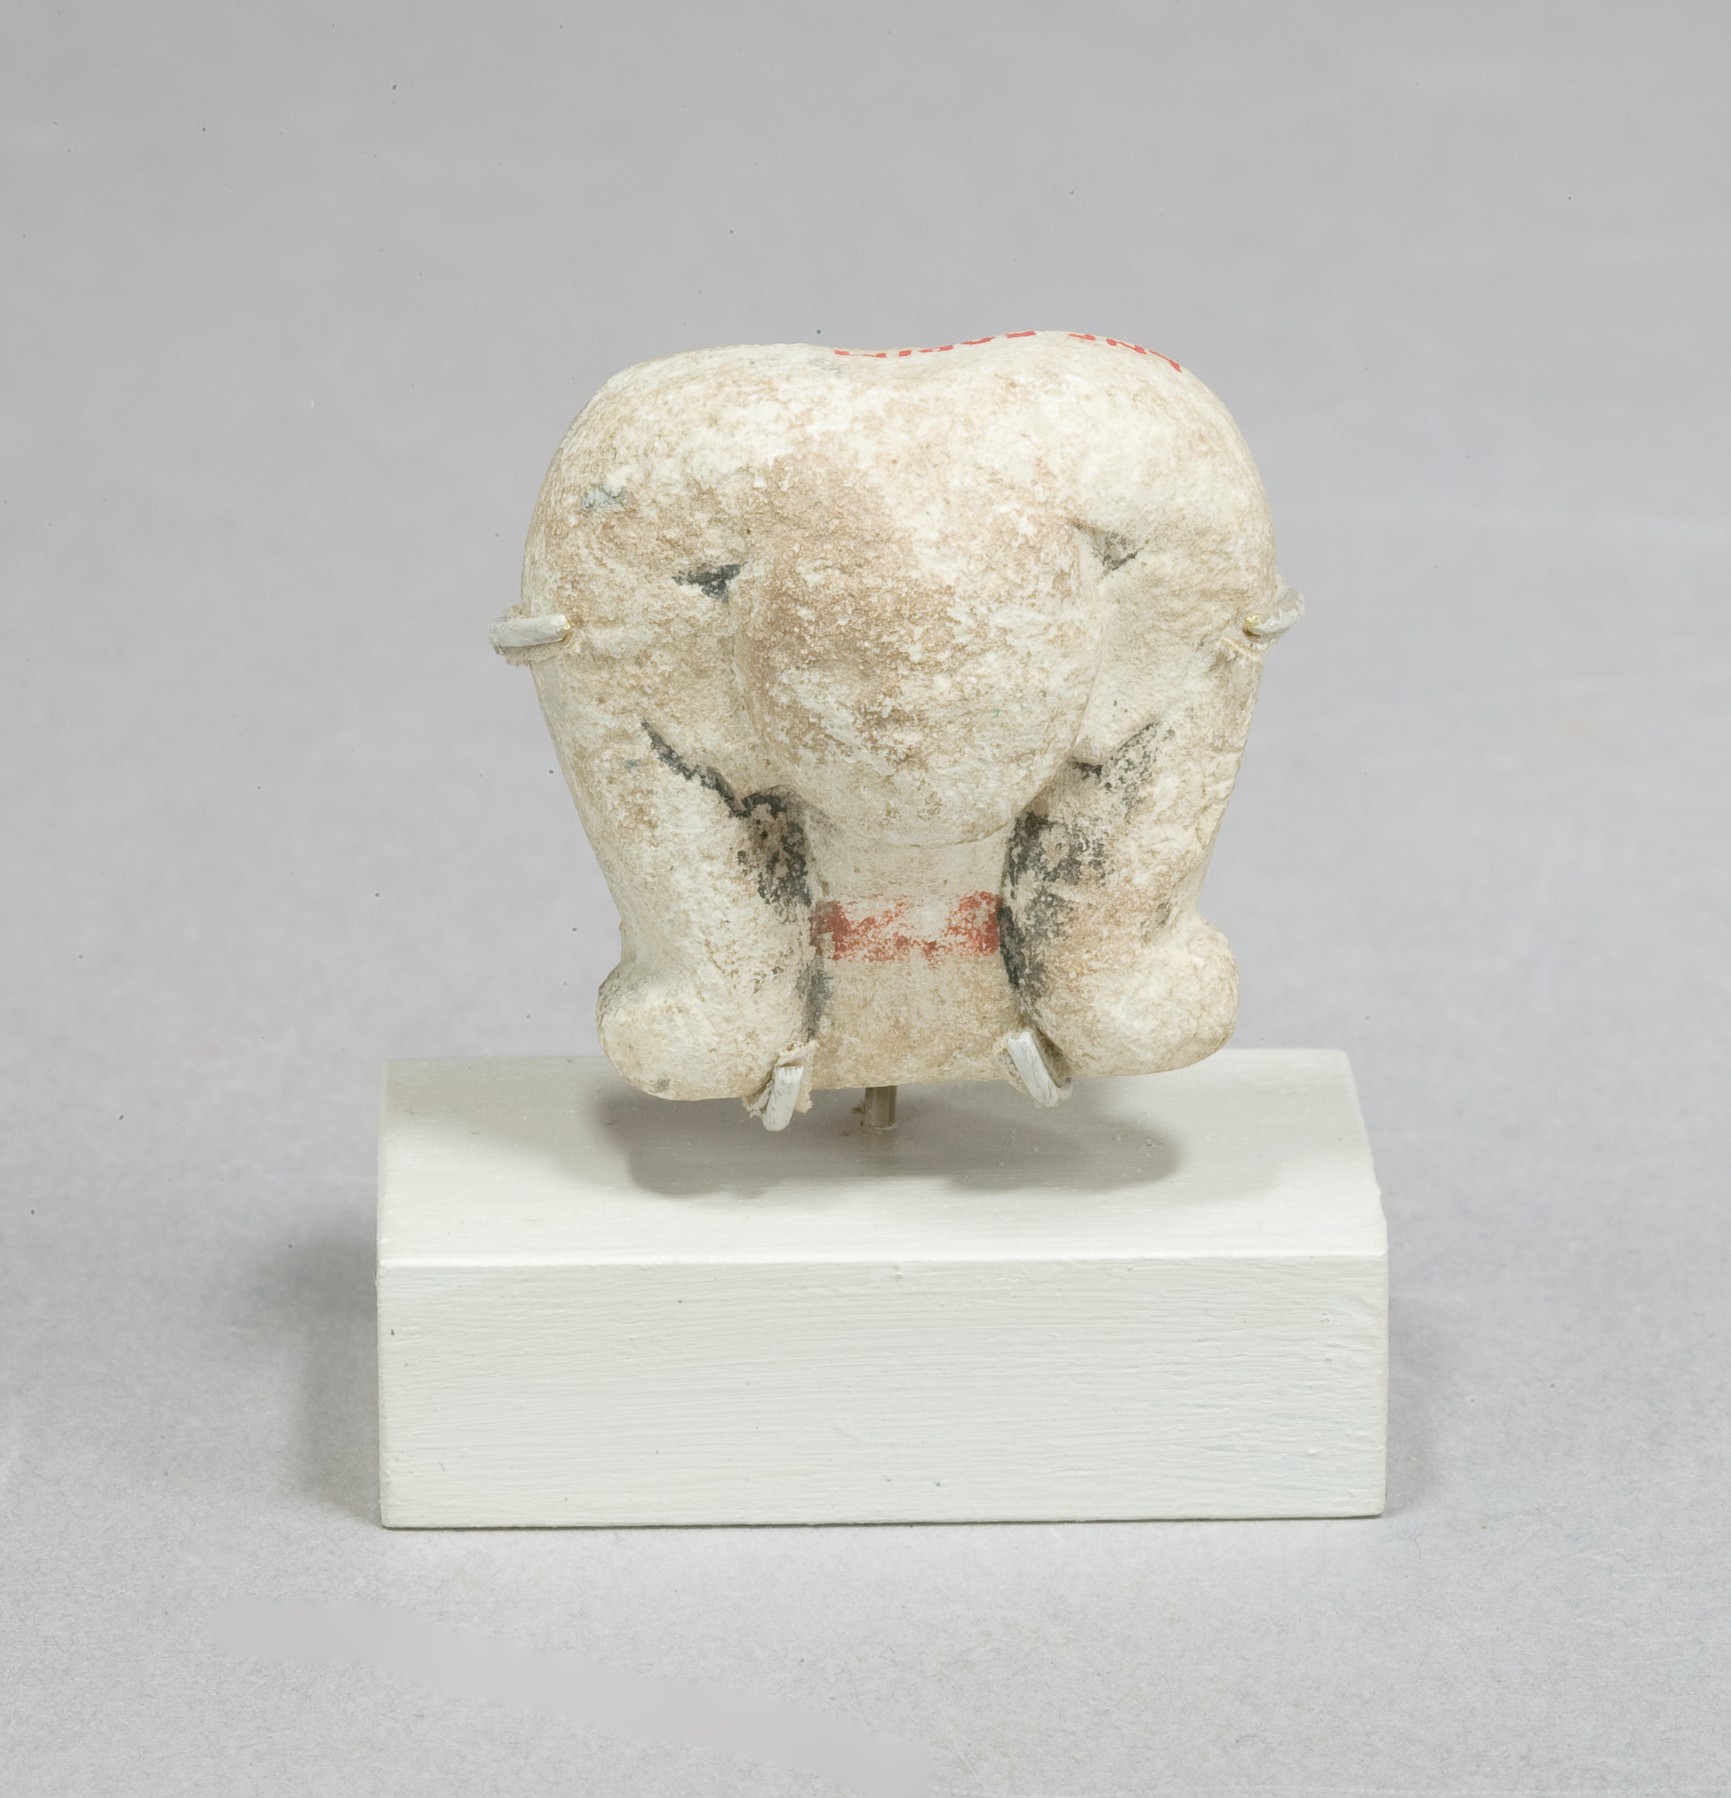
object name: head, hathor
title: Head of Hathor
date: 1981-1640 BCE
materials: pottery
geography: egypt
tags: heads,hathor